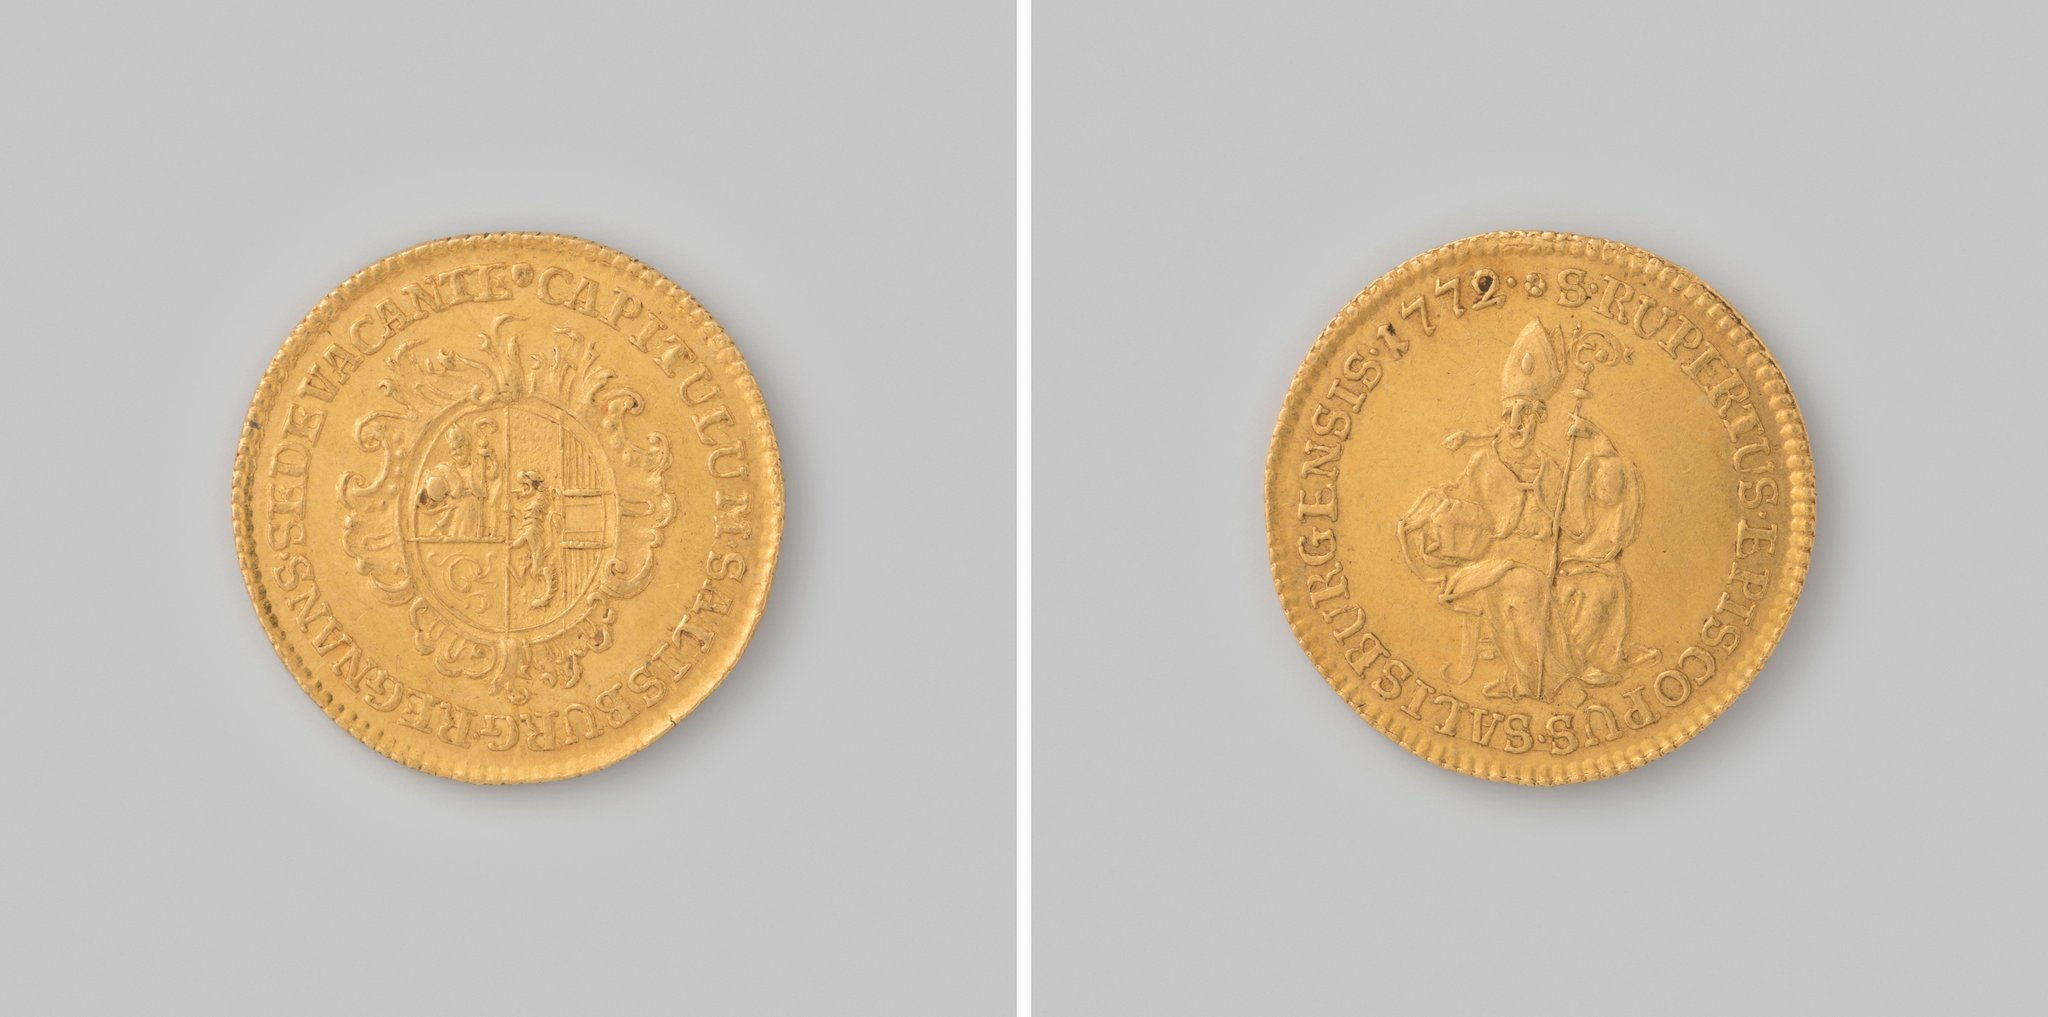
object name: ducat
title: Dukaat uit het aartsbisdom Salzburg, sede vacante,1772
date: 1772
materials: gold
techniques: striking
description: Gouden munt. Voorzijde: versierd wapenschild van het aartsbisdom. Keerzijde: zittende heilige Rupert met mijter en staf. Jaartal aan het eind van het omschrift. Kabelrand.